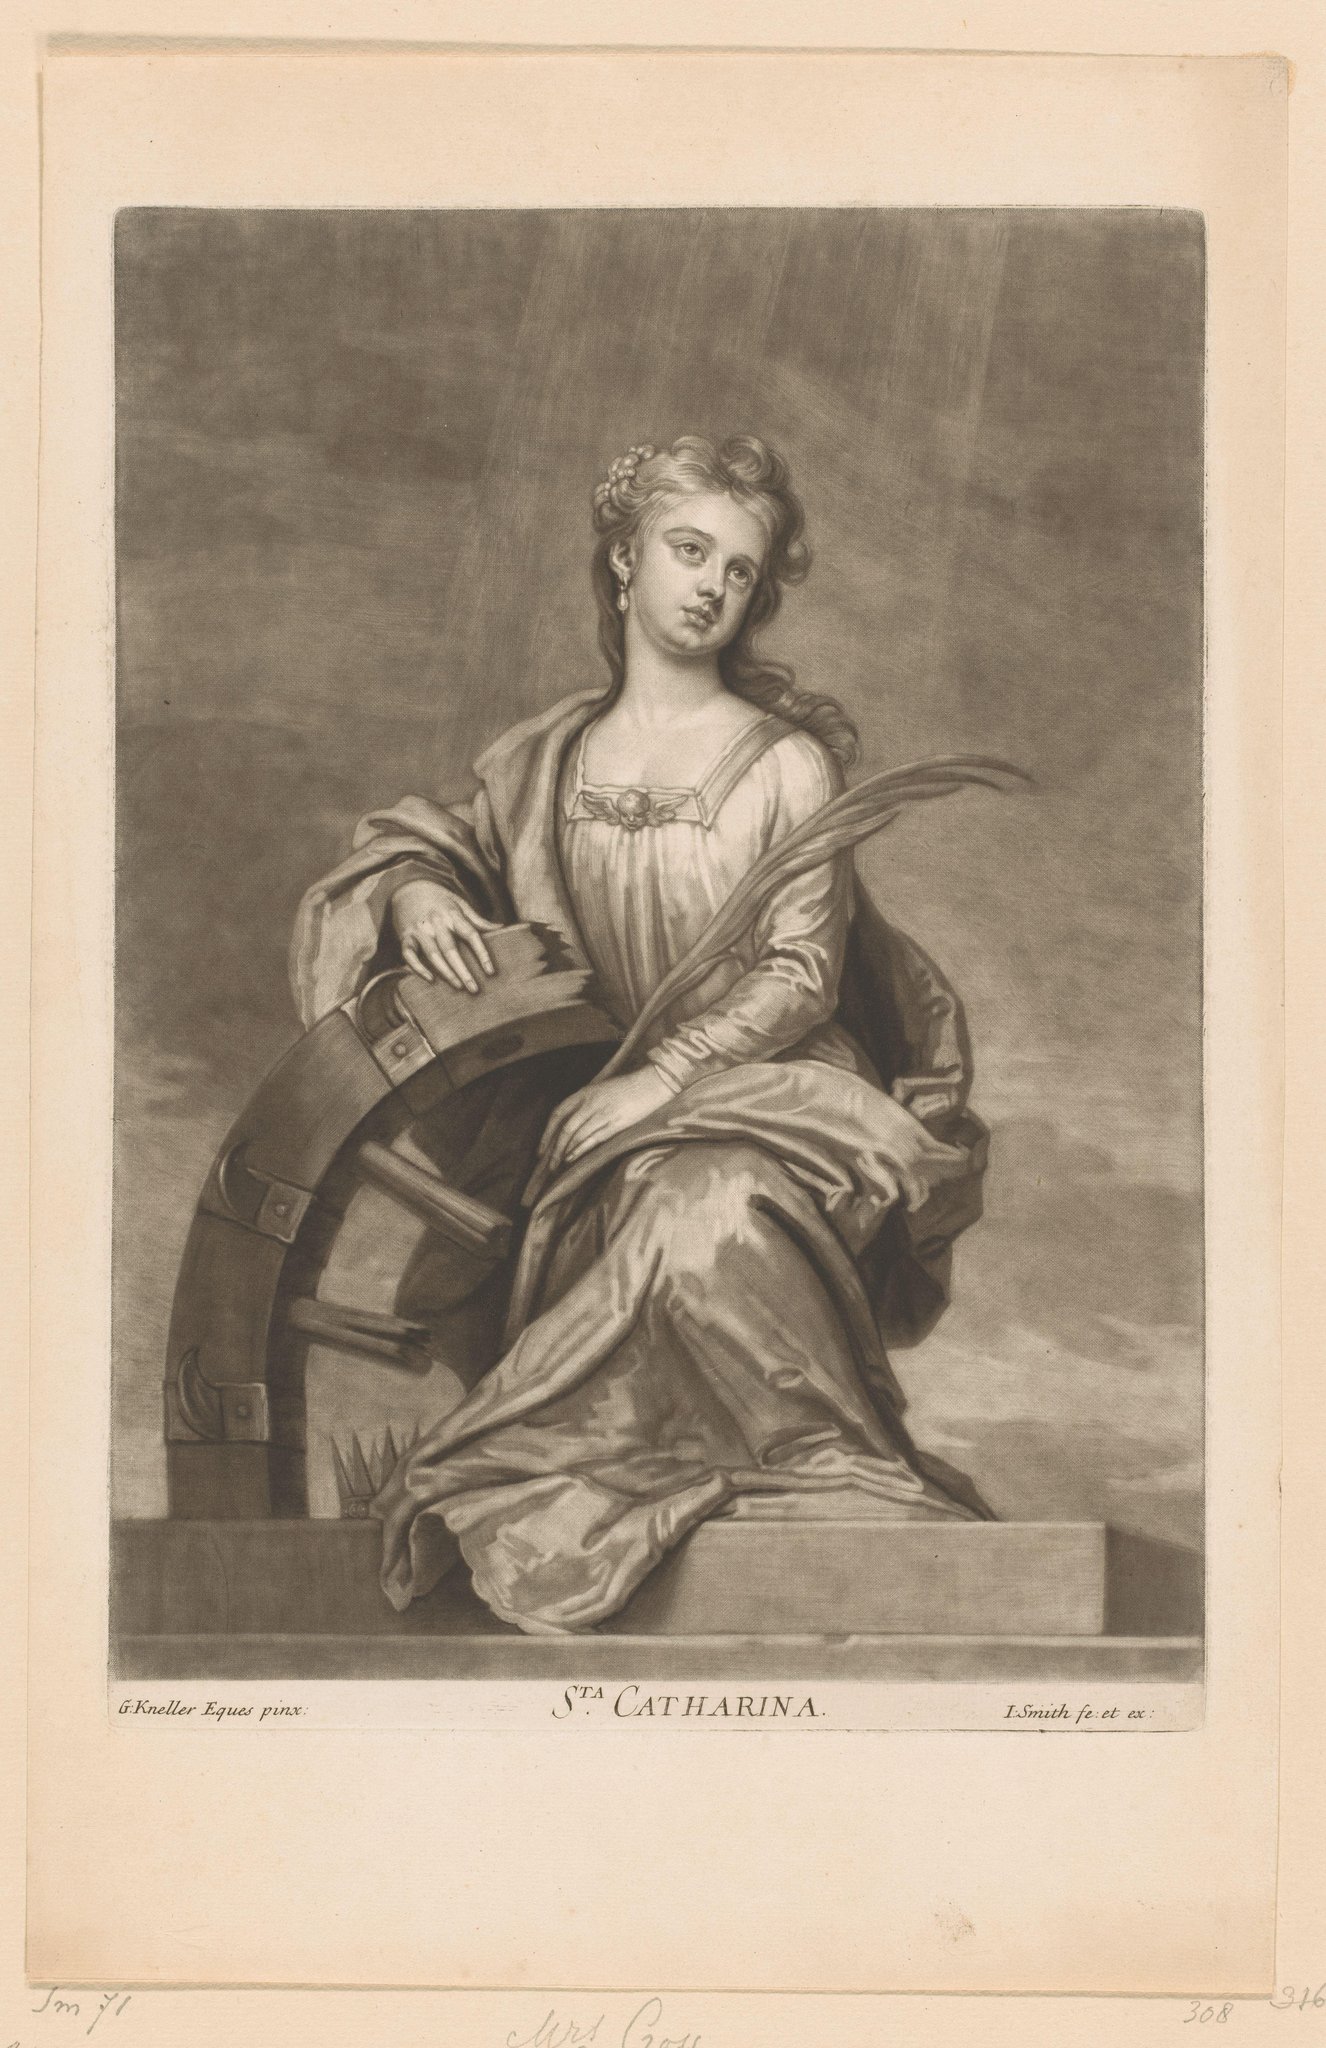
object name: print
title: Portret van mevrouw Cross als H. Catharina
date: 1697-1742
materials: paper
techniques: mezzotint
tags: the virgin martyr catherine of alexandria; possible attributes: book, crown, emperor maxentius, palm-branch, ring, sword, wheel, historical persons, actor, actress (non-work situations)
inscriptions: collector's mark: Lugt 240